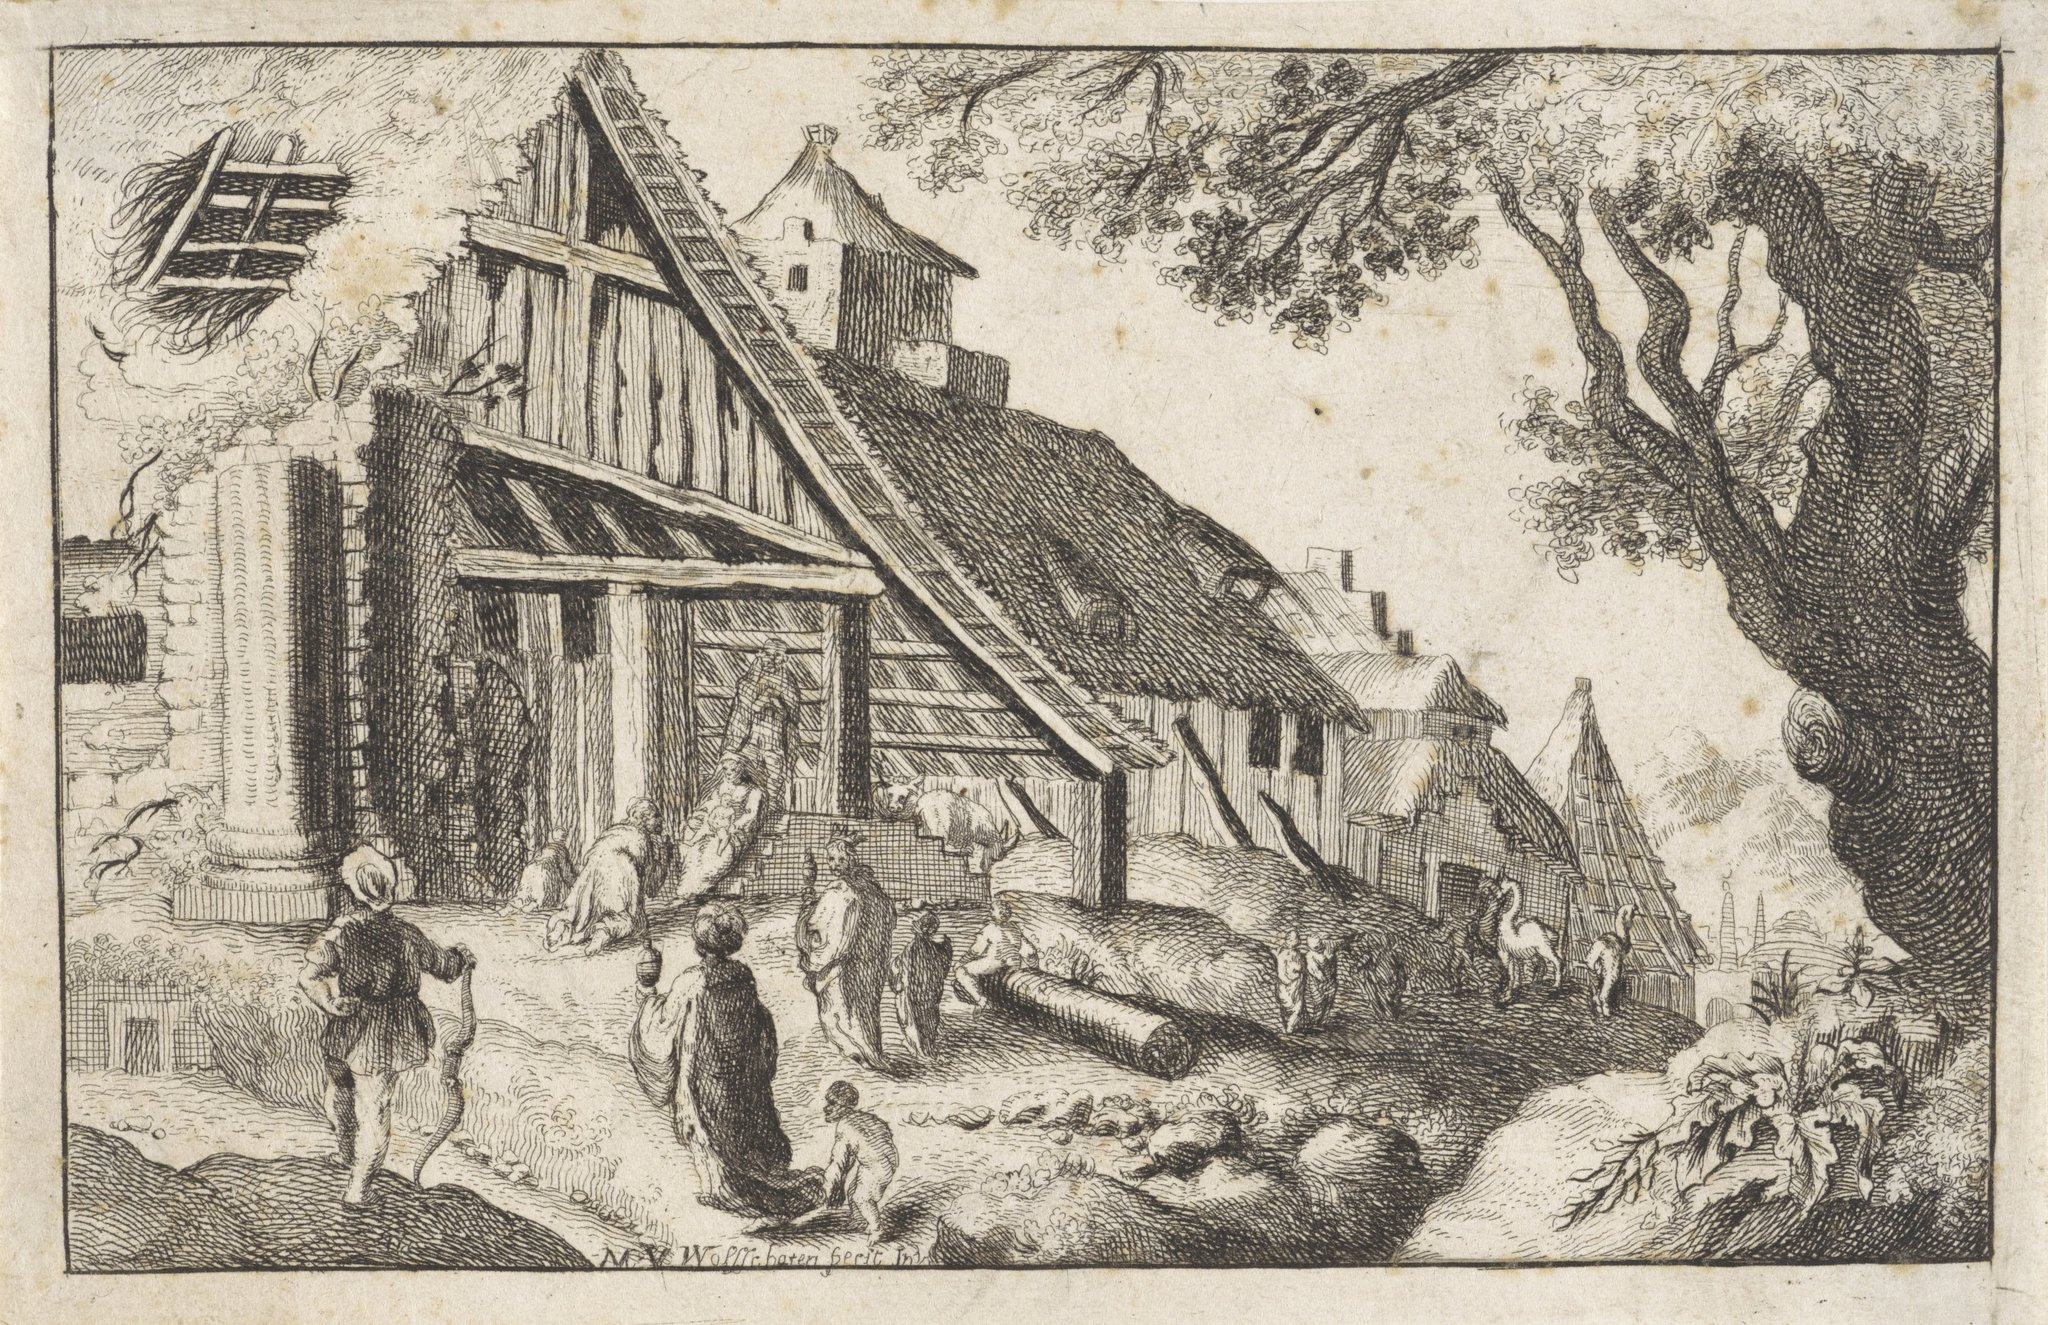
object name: print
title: Aanbidding der koningen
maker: m. van wolsschaten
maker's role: print maker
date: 1600-1699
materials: paper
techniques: etching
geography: southern netherlands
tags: adoration of the kings: the wise men present their gifts to the christ-child (gold, frankincense and myrrh)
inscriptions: collector's mark: Lugt 2228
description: In een open stal zit Maria met het Christuskind op haar schoot. Achter haar staat Jozef. Eén koning knielt voor haar en de twee overige koningen hebben haar bijna bereikt. Linksvoor een man met een boog.